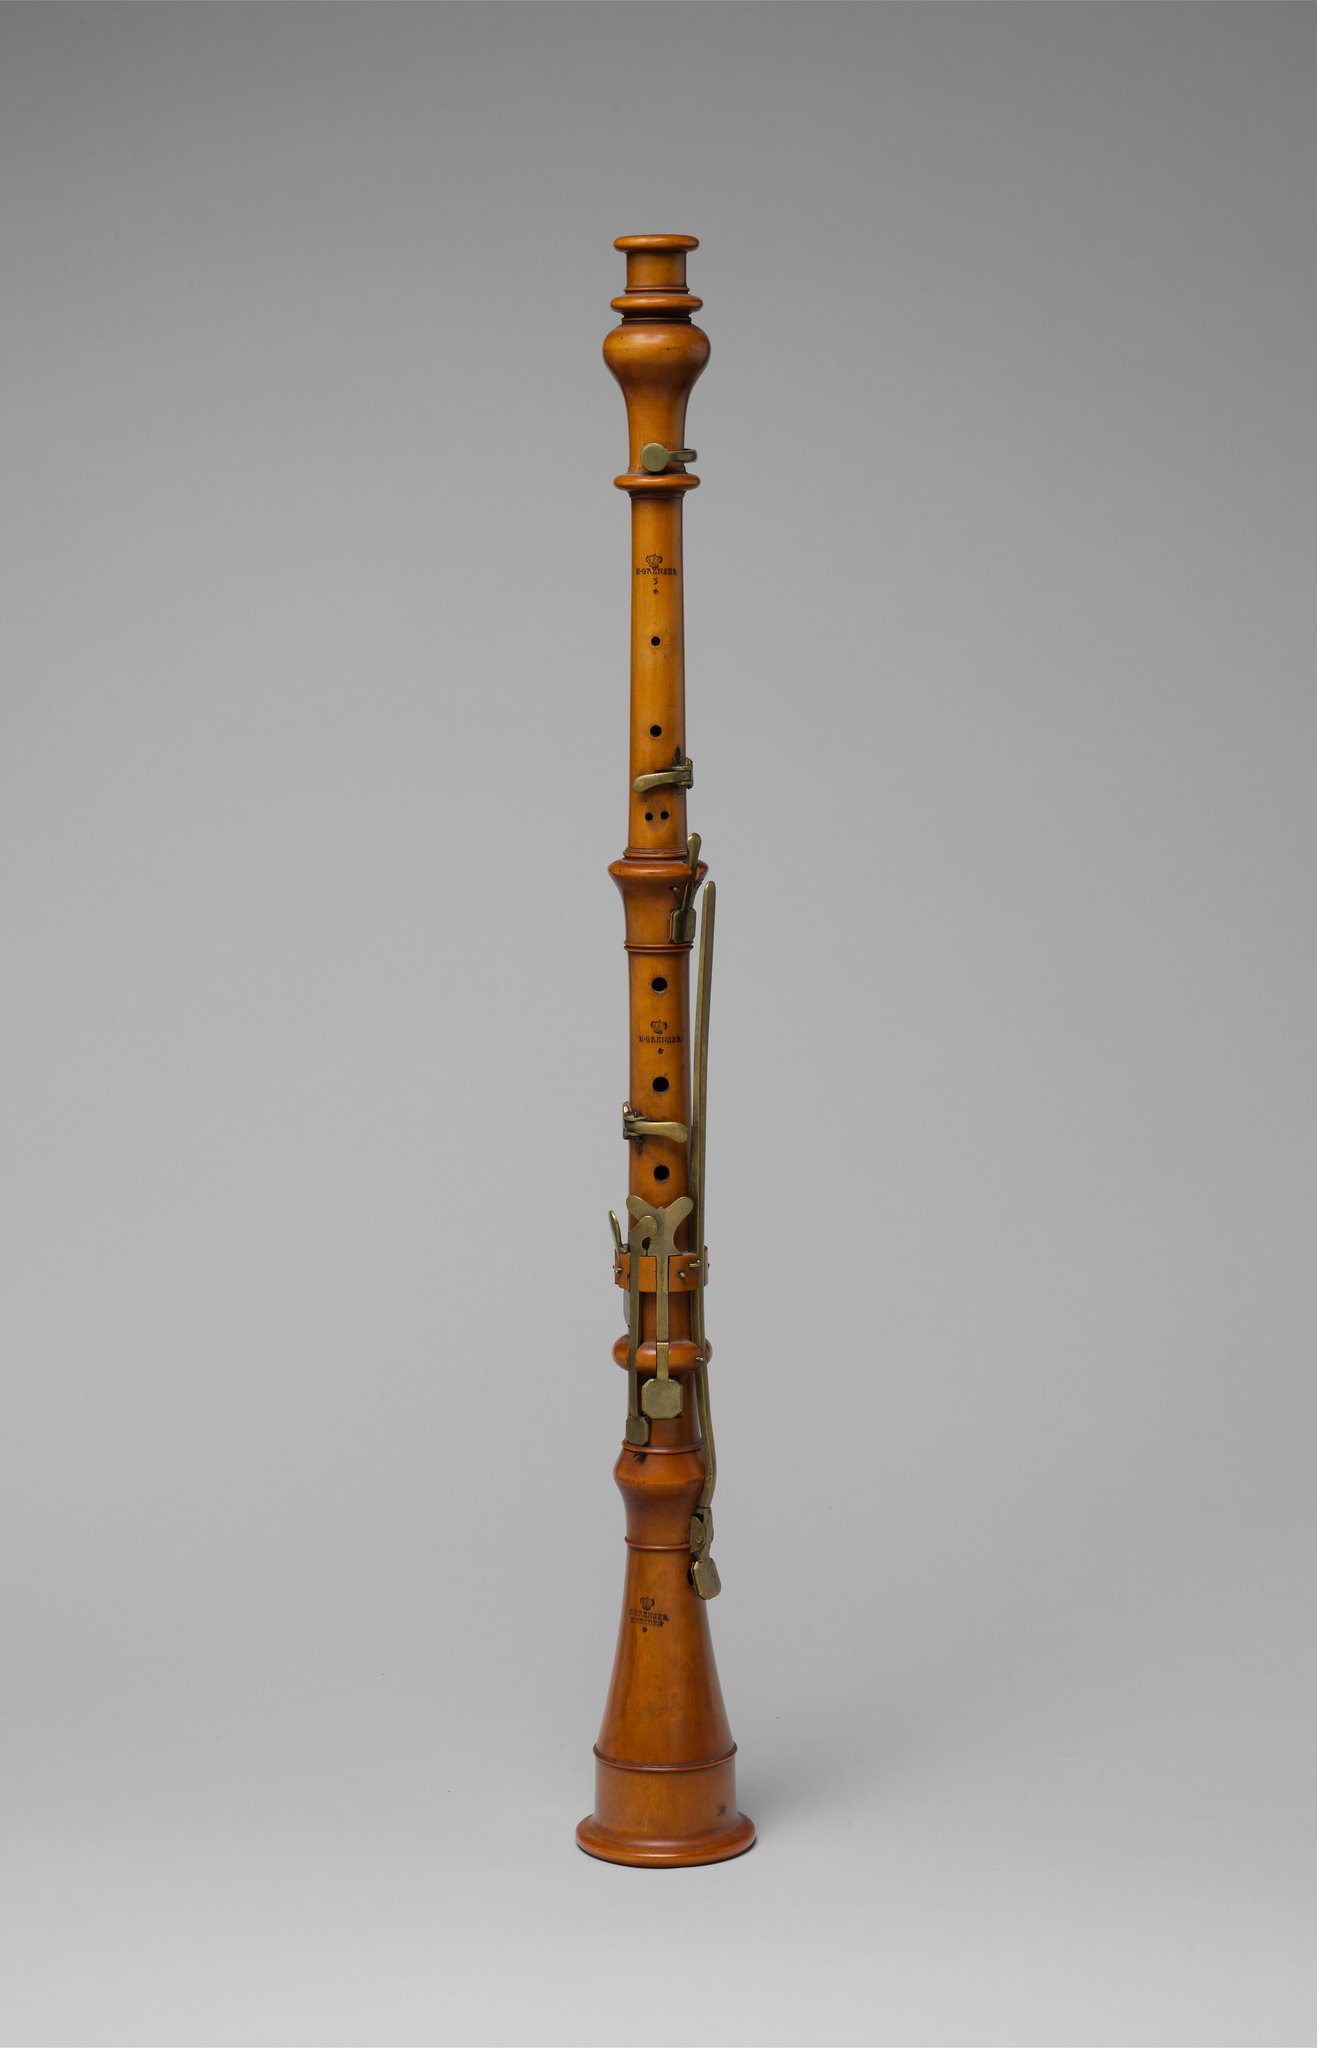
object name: oboe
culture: german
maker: heinrich grenser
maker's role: musical instrument maker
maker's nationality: german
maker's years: 1764-1813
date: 1806-1813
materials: wood, brass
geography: germany